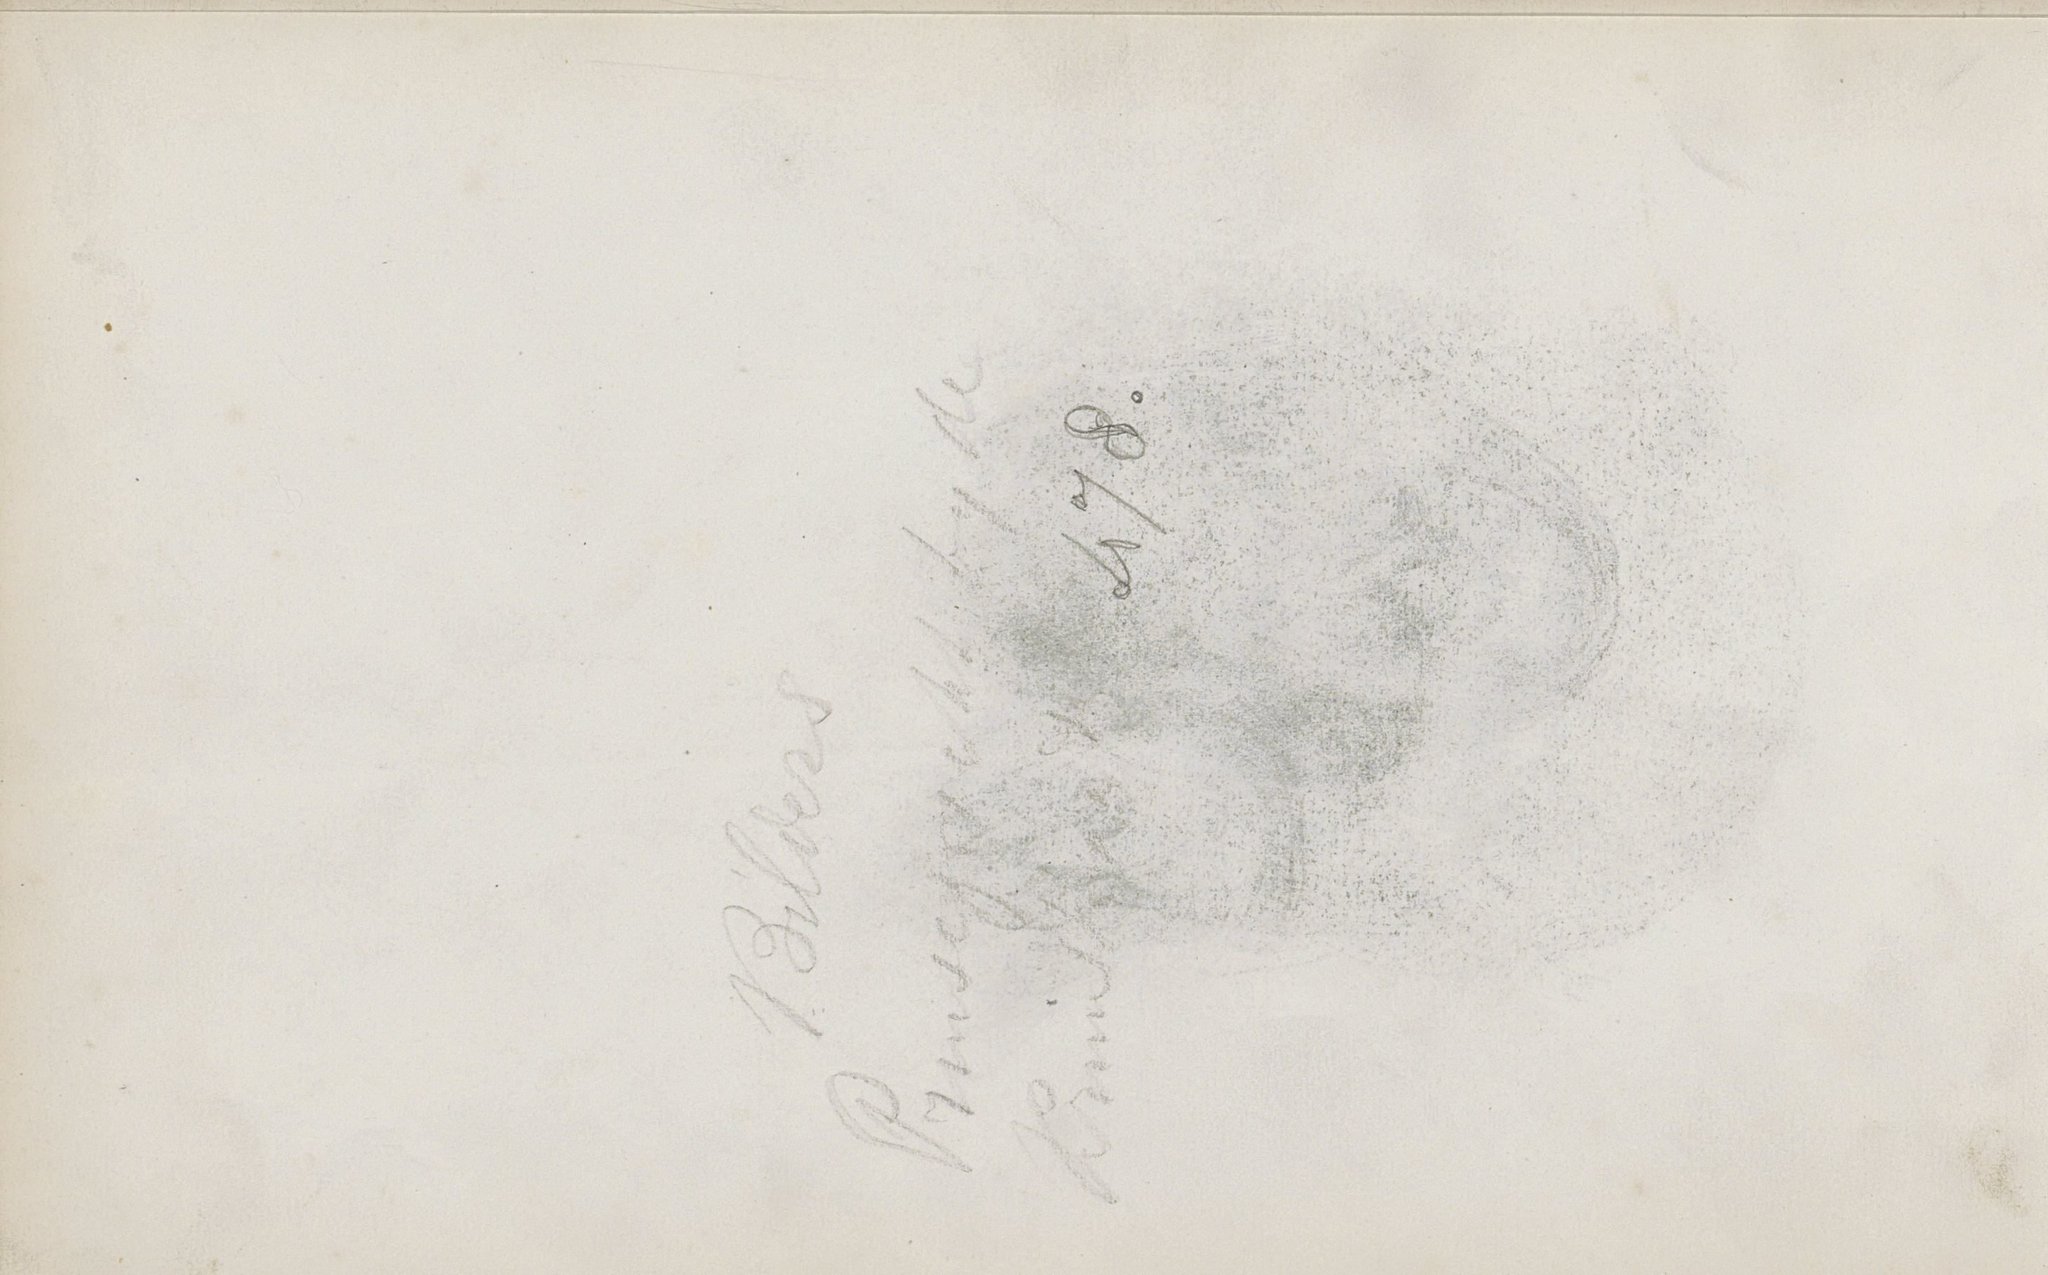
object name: sketchbook leaf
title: Naam en adres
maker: bastiaan de poorter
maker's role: painter, print maker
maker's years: 1813-1880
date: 1858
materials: paper, pencil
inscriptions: address: ‘Bilders/ Prinsegracht bij de/ Kruis[...] 478’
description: Blad 17 verso uit een gecombineerd album amicorum en schetsboek met in totaal 39 bladen.